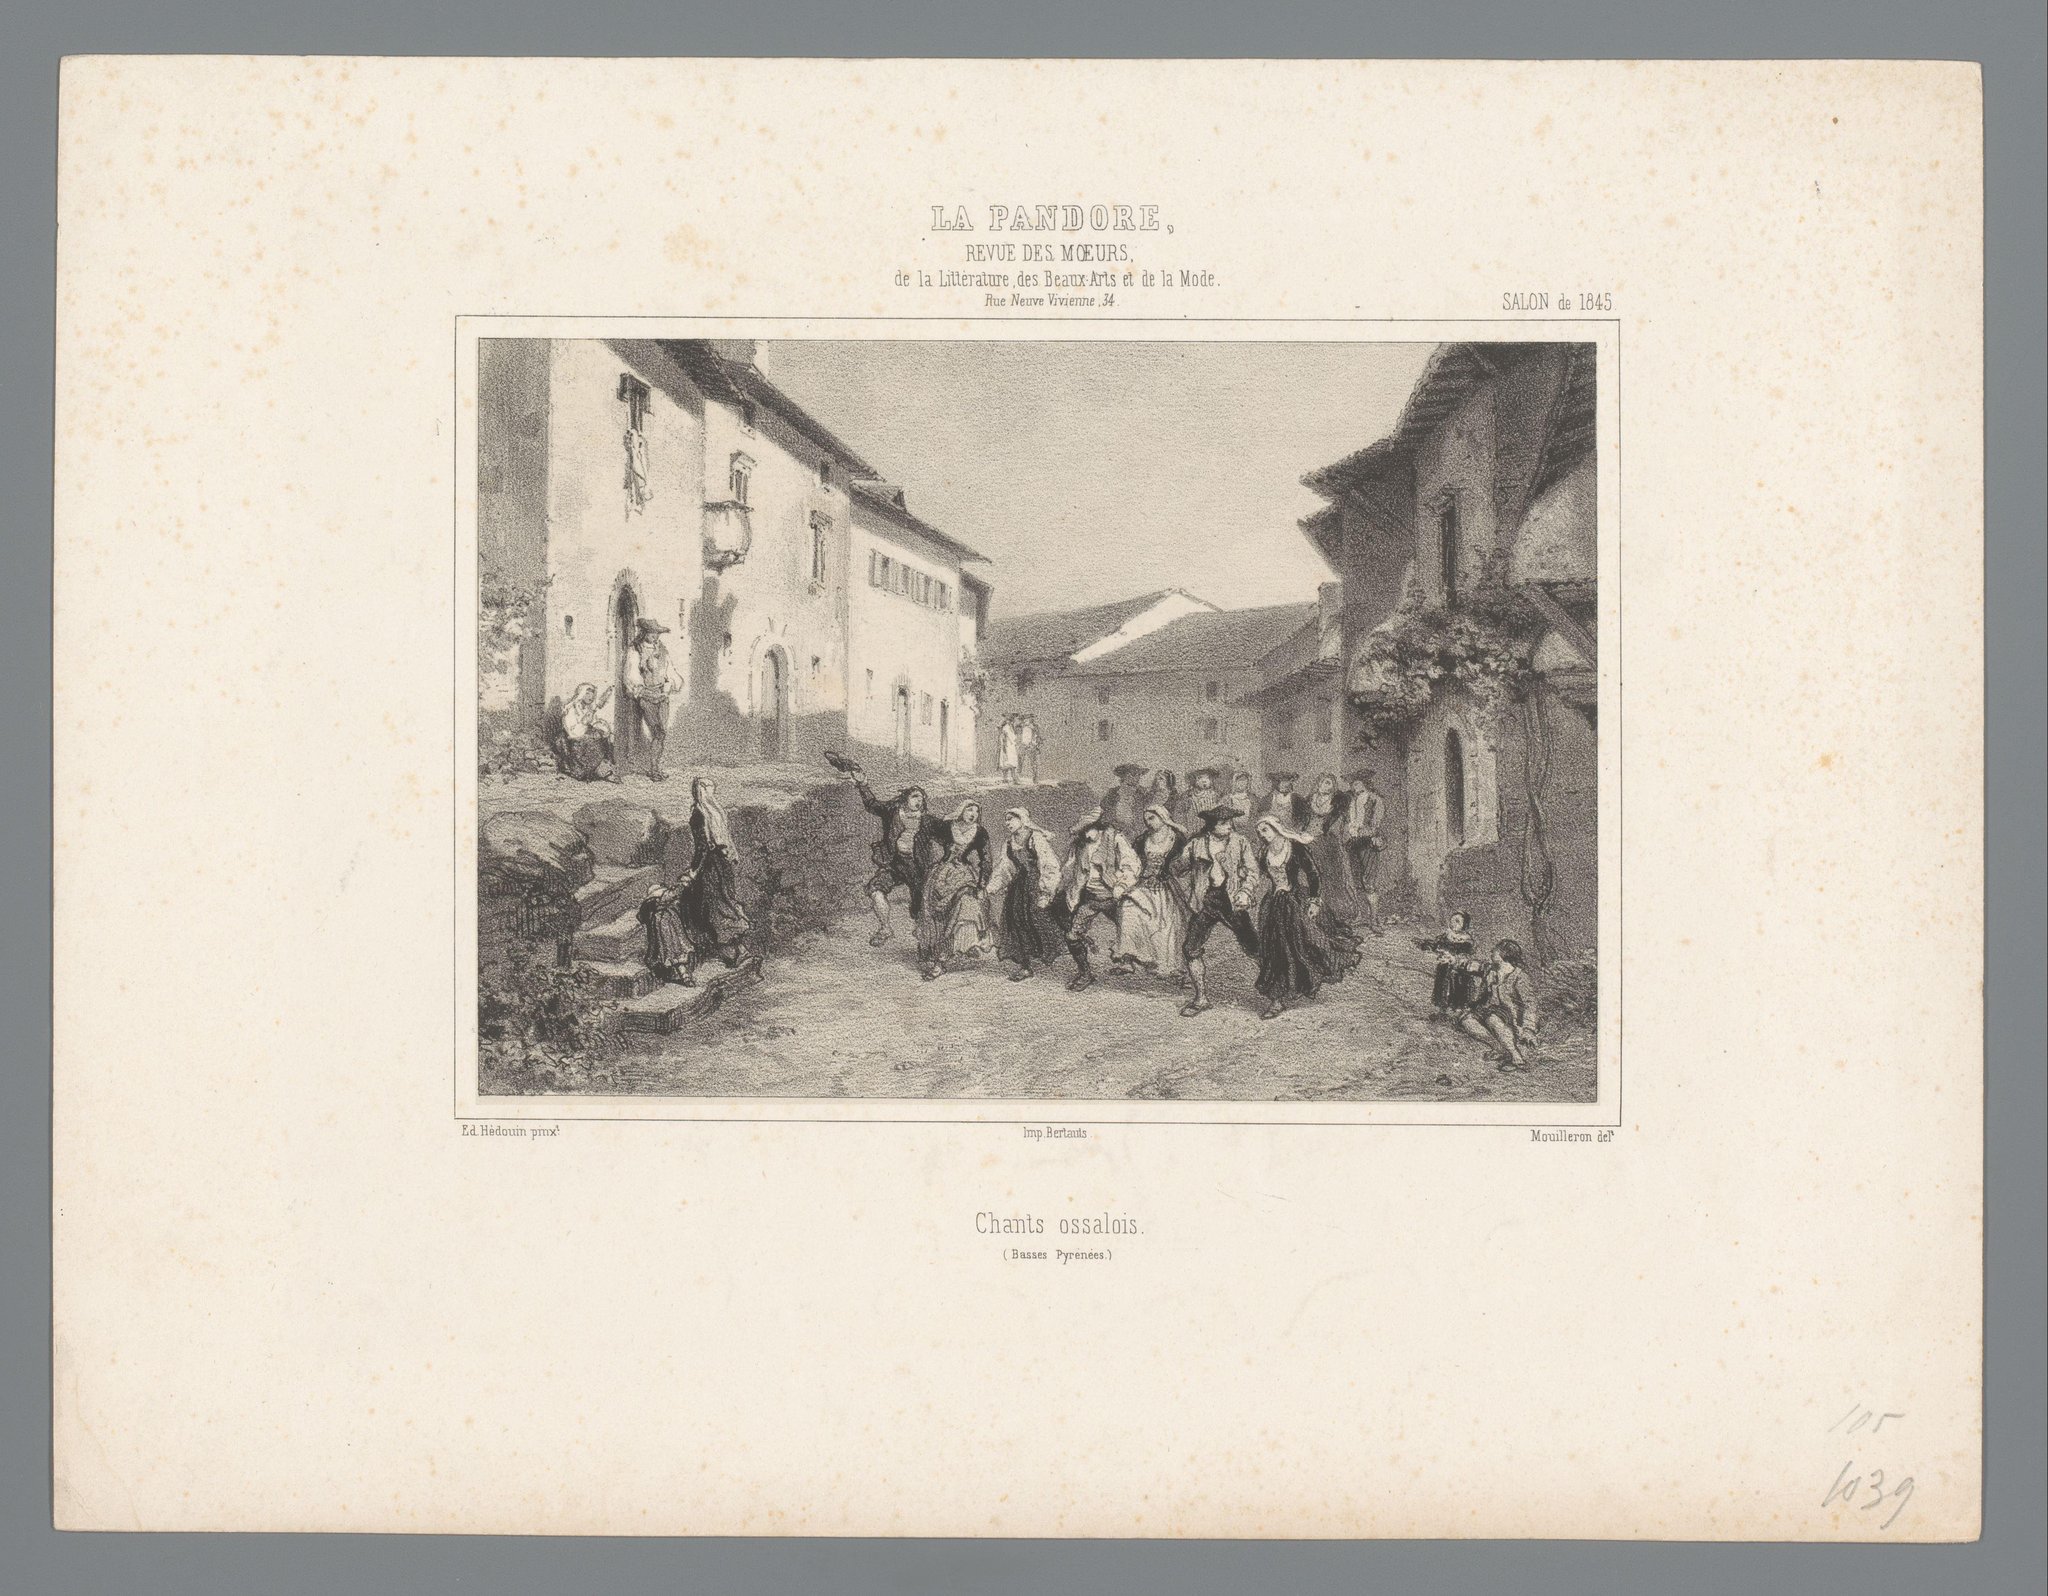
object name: print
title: Groep zingende en dansende bewoners uit de vallei van Ossau in de Pyreneeën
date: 1845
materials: paper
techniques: lithograph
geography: paris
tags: vocal music, singing, villagers; villeins (dutch: 'dorpers')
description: Prent verschenen als bijlage bij: La Pandore, revue des moeurs, de la littérature, des beaux-arts et de la mode (1845), nr. 2, 20 november 1845.